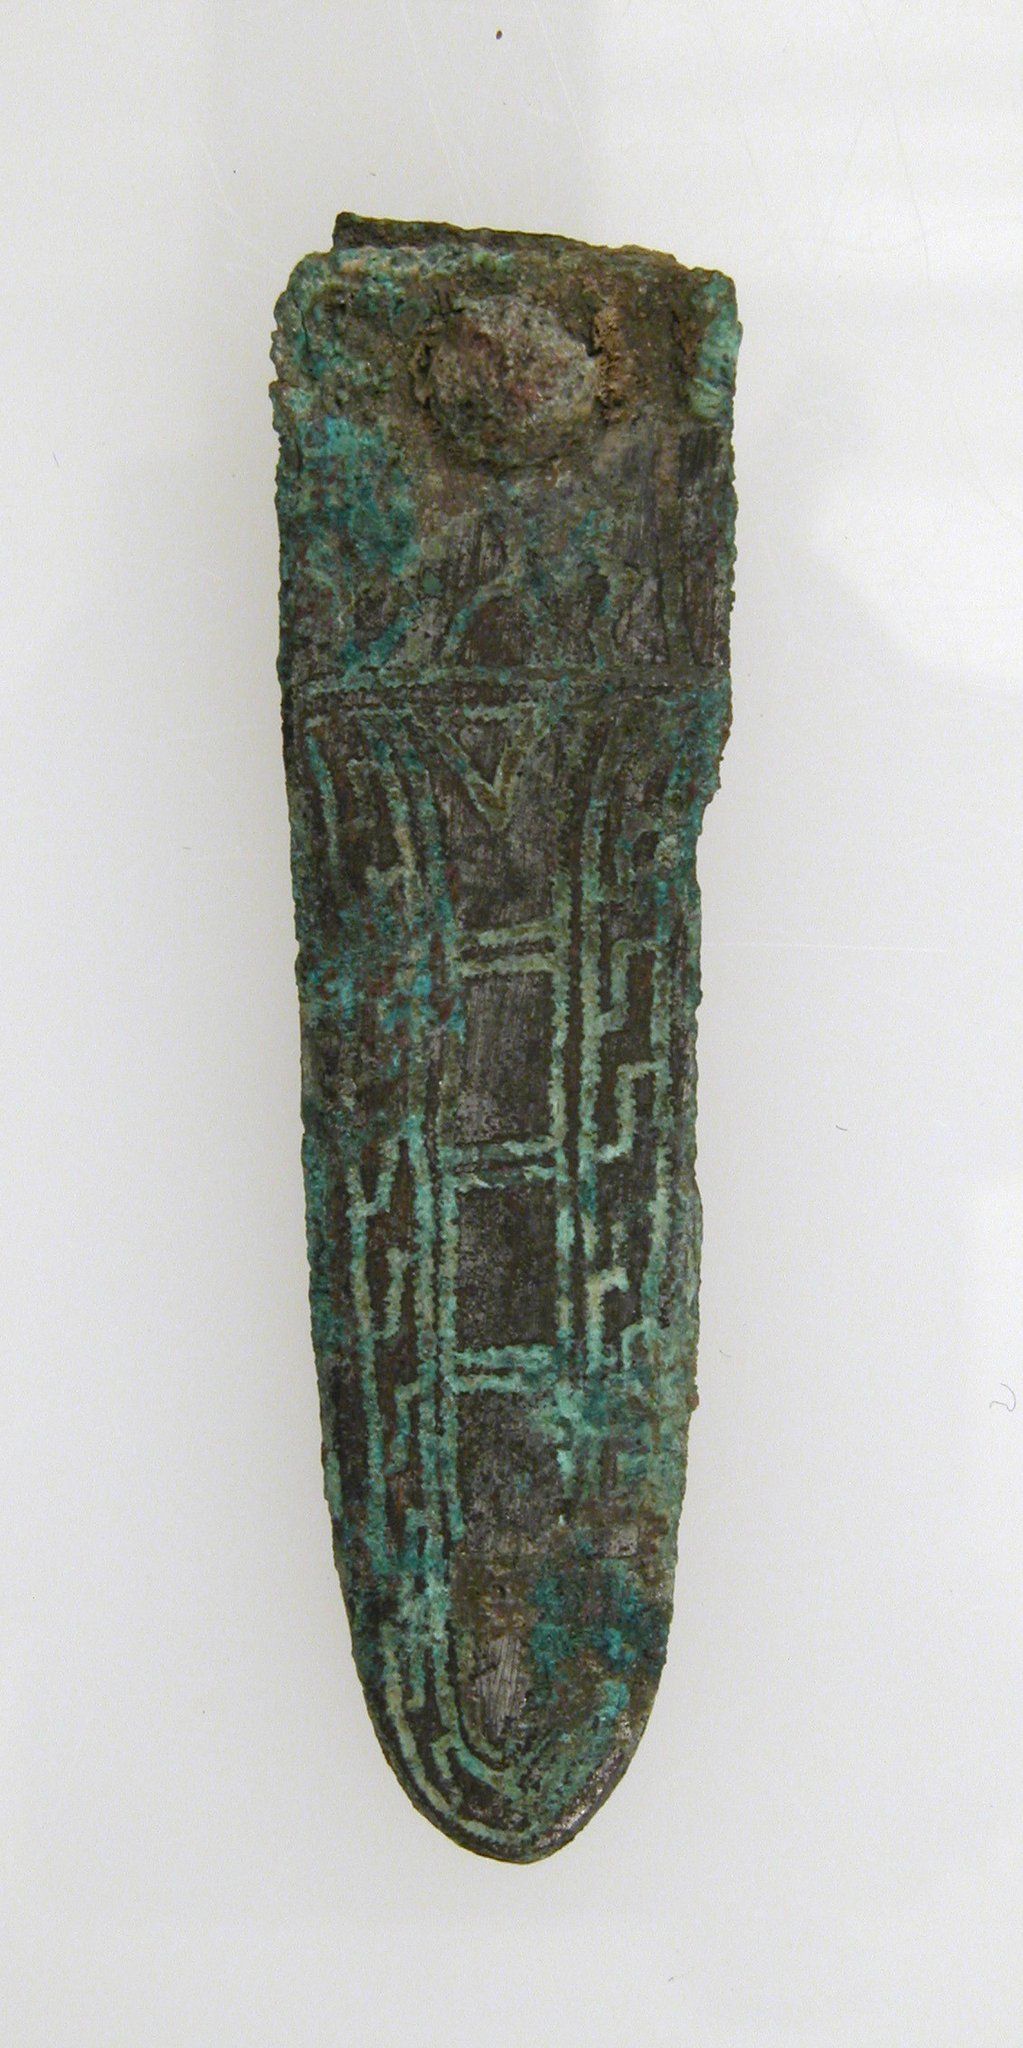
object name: ferret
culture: frankish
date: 501-700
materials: copper alloy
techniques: silvered